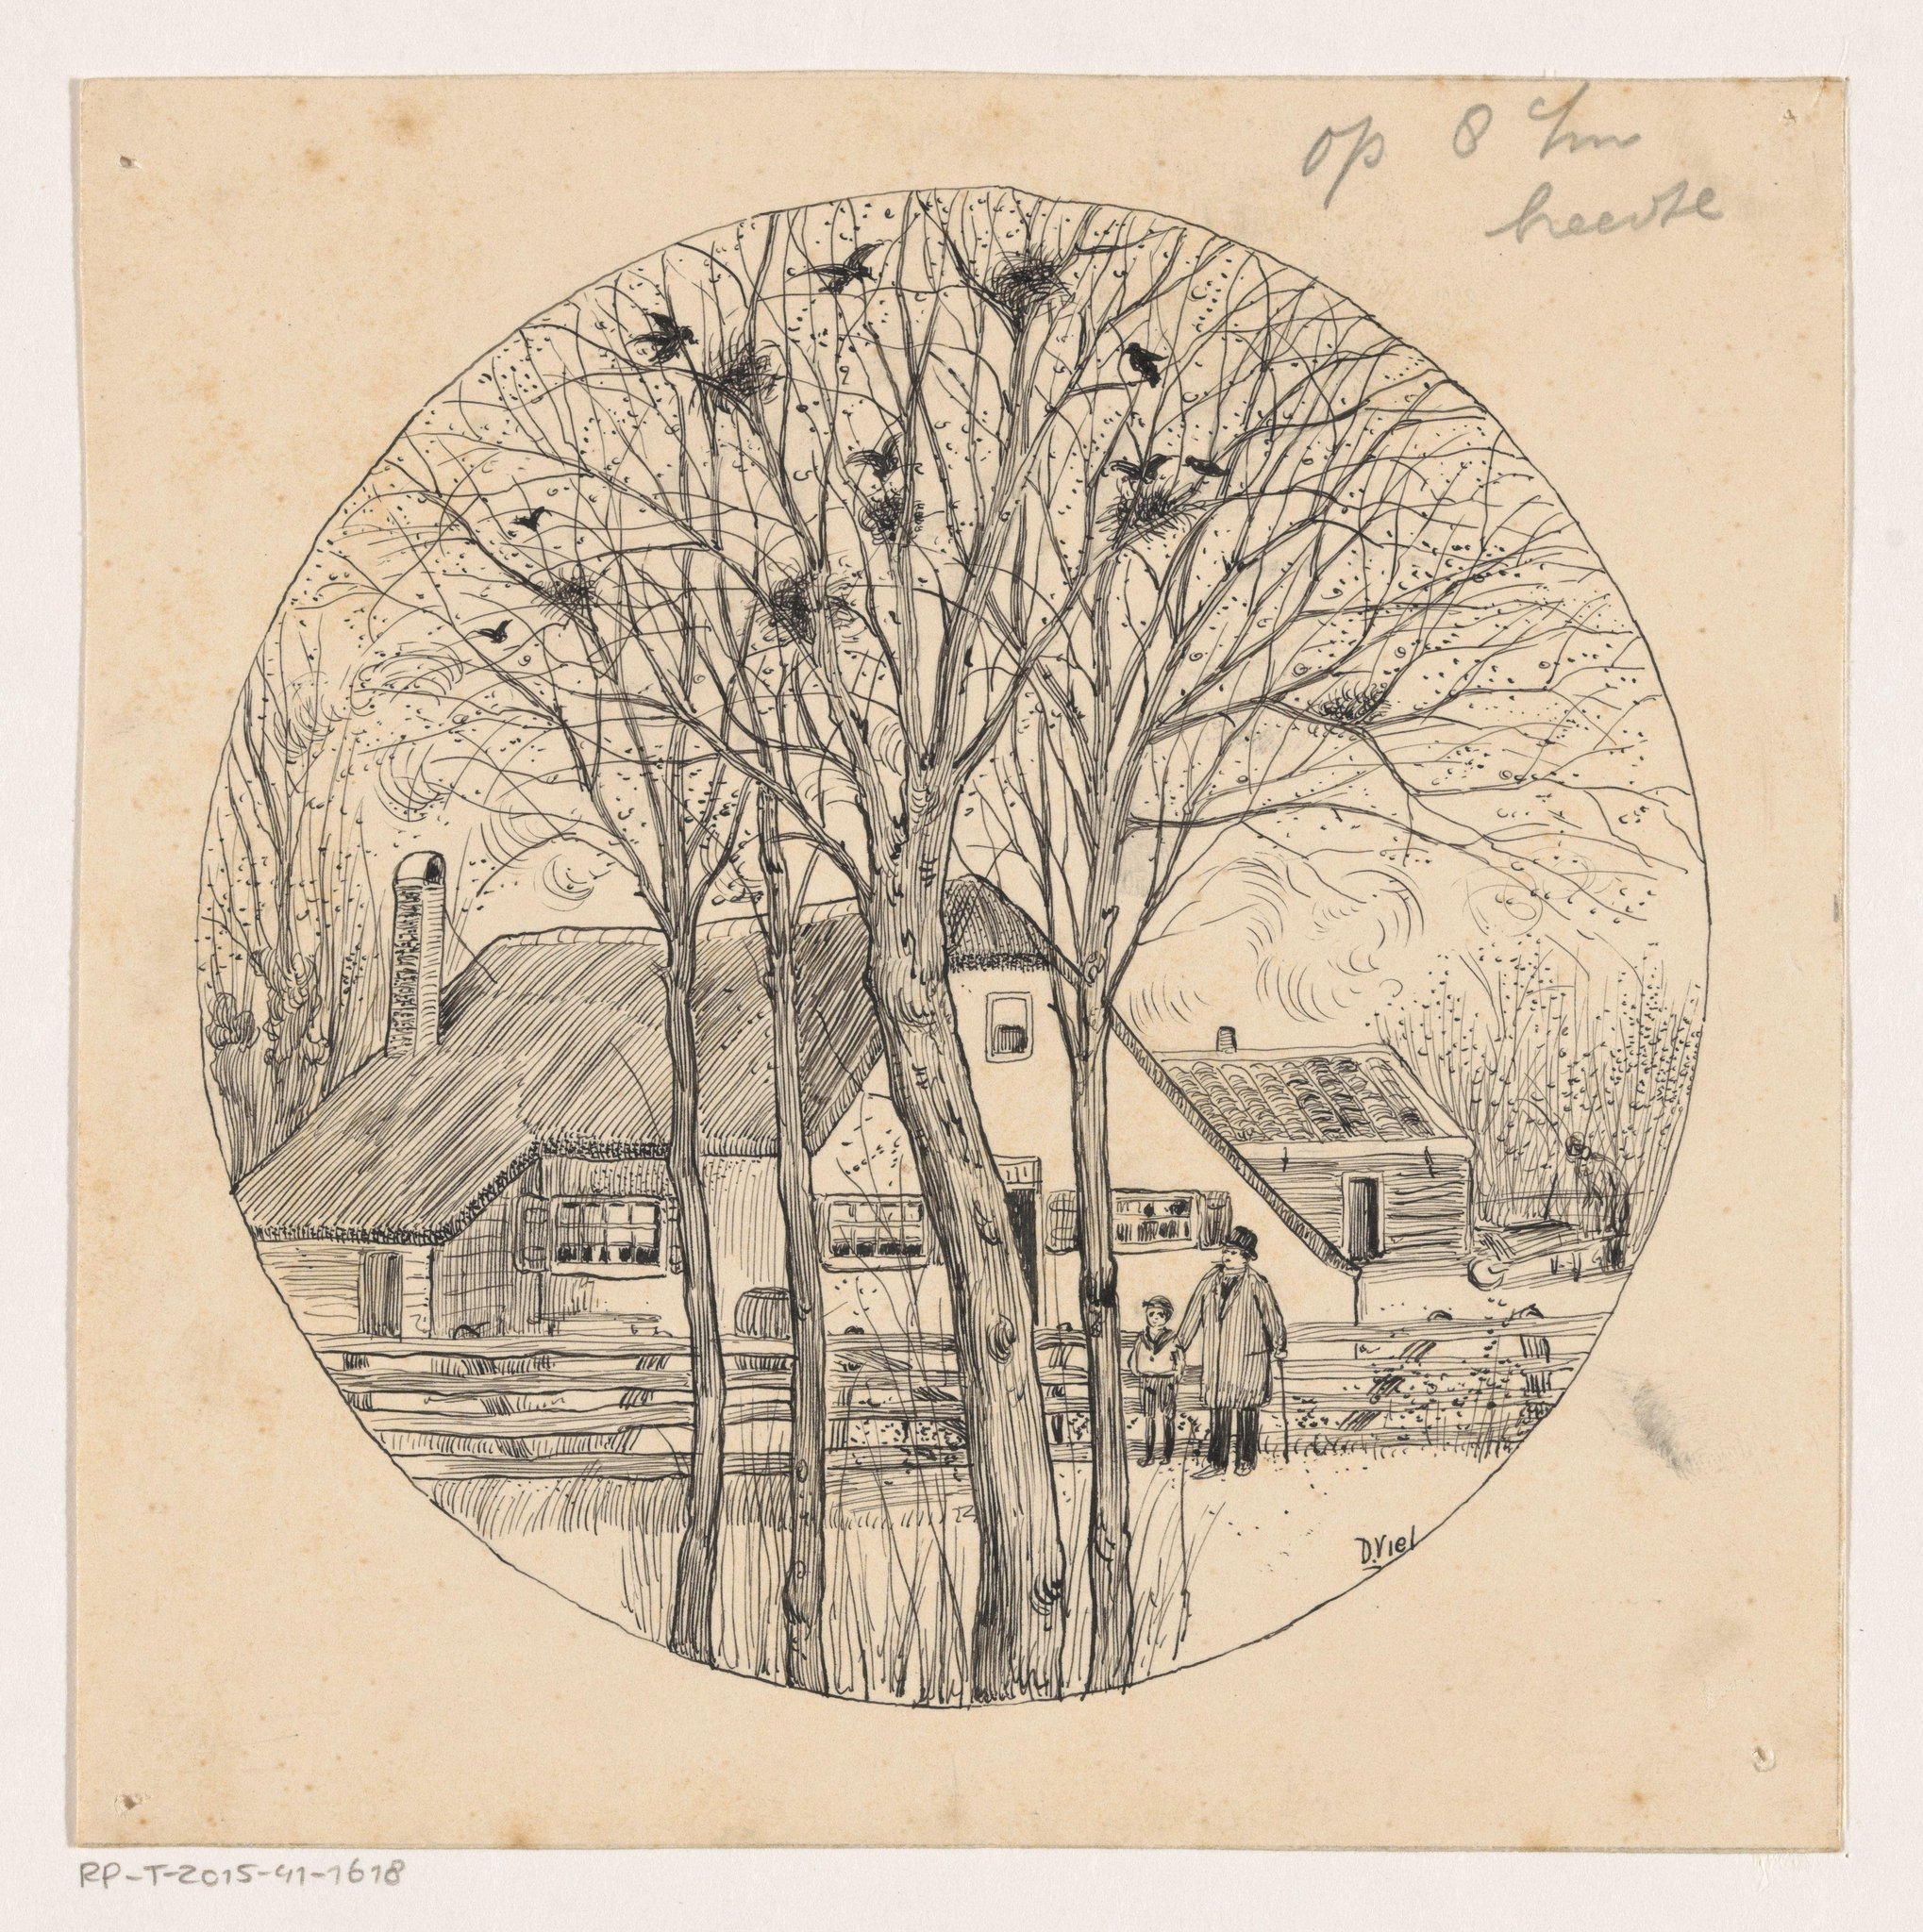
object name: boekillustratie ontwerp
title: Vader en zoon kijken naar kraai Gerrit in een boom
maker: d. viel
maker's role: draughtsman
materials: ink, paper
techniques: pen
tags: song-birds: crow, father and son(s) (family group), farm (building)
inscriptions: signature: ‘D. Viel’, :, collector's mark: Lugt 2228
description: Ontwerp voor: Dietz, Henriette e.a. Dappere Wim: vertellingen voor jongens en meisjes. Ons thuis-serie. Amsterdam: Veen, 1924.